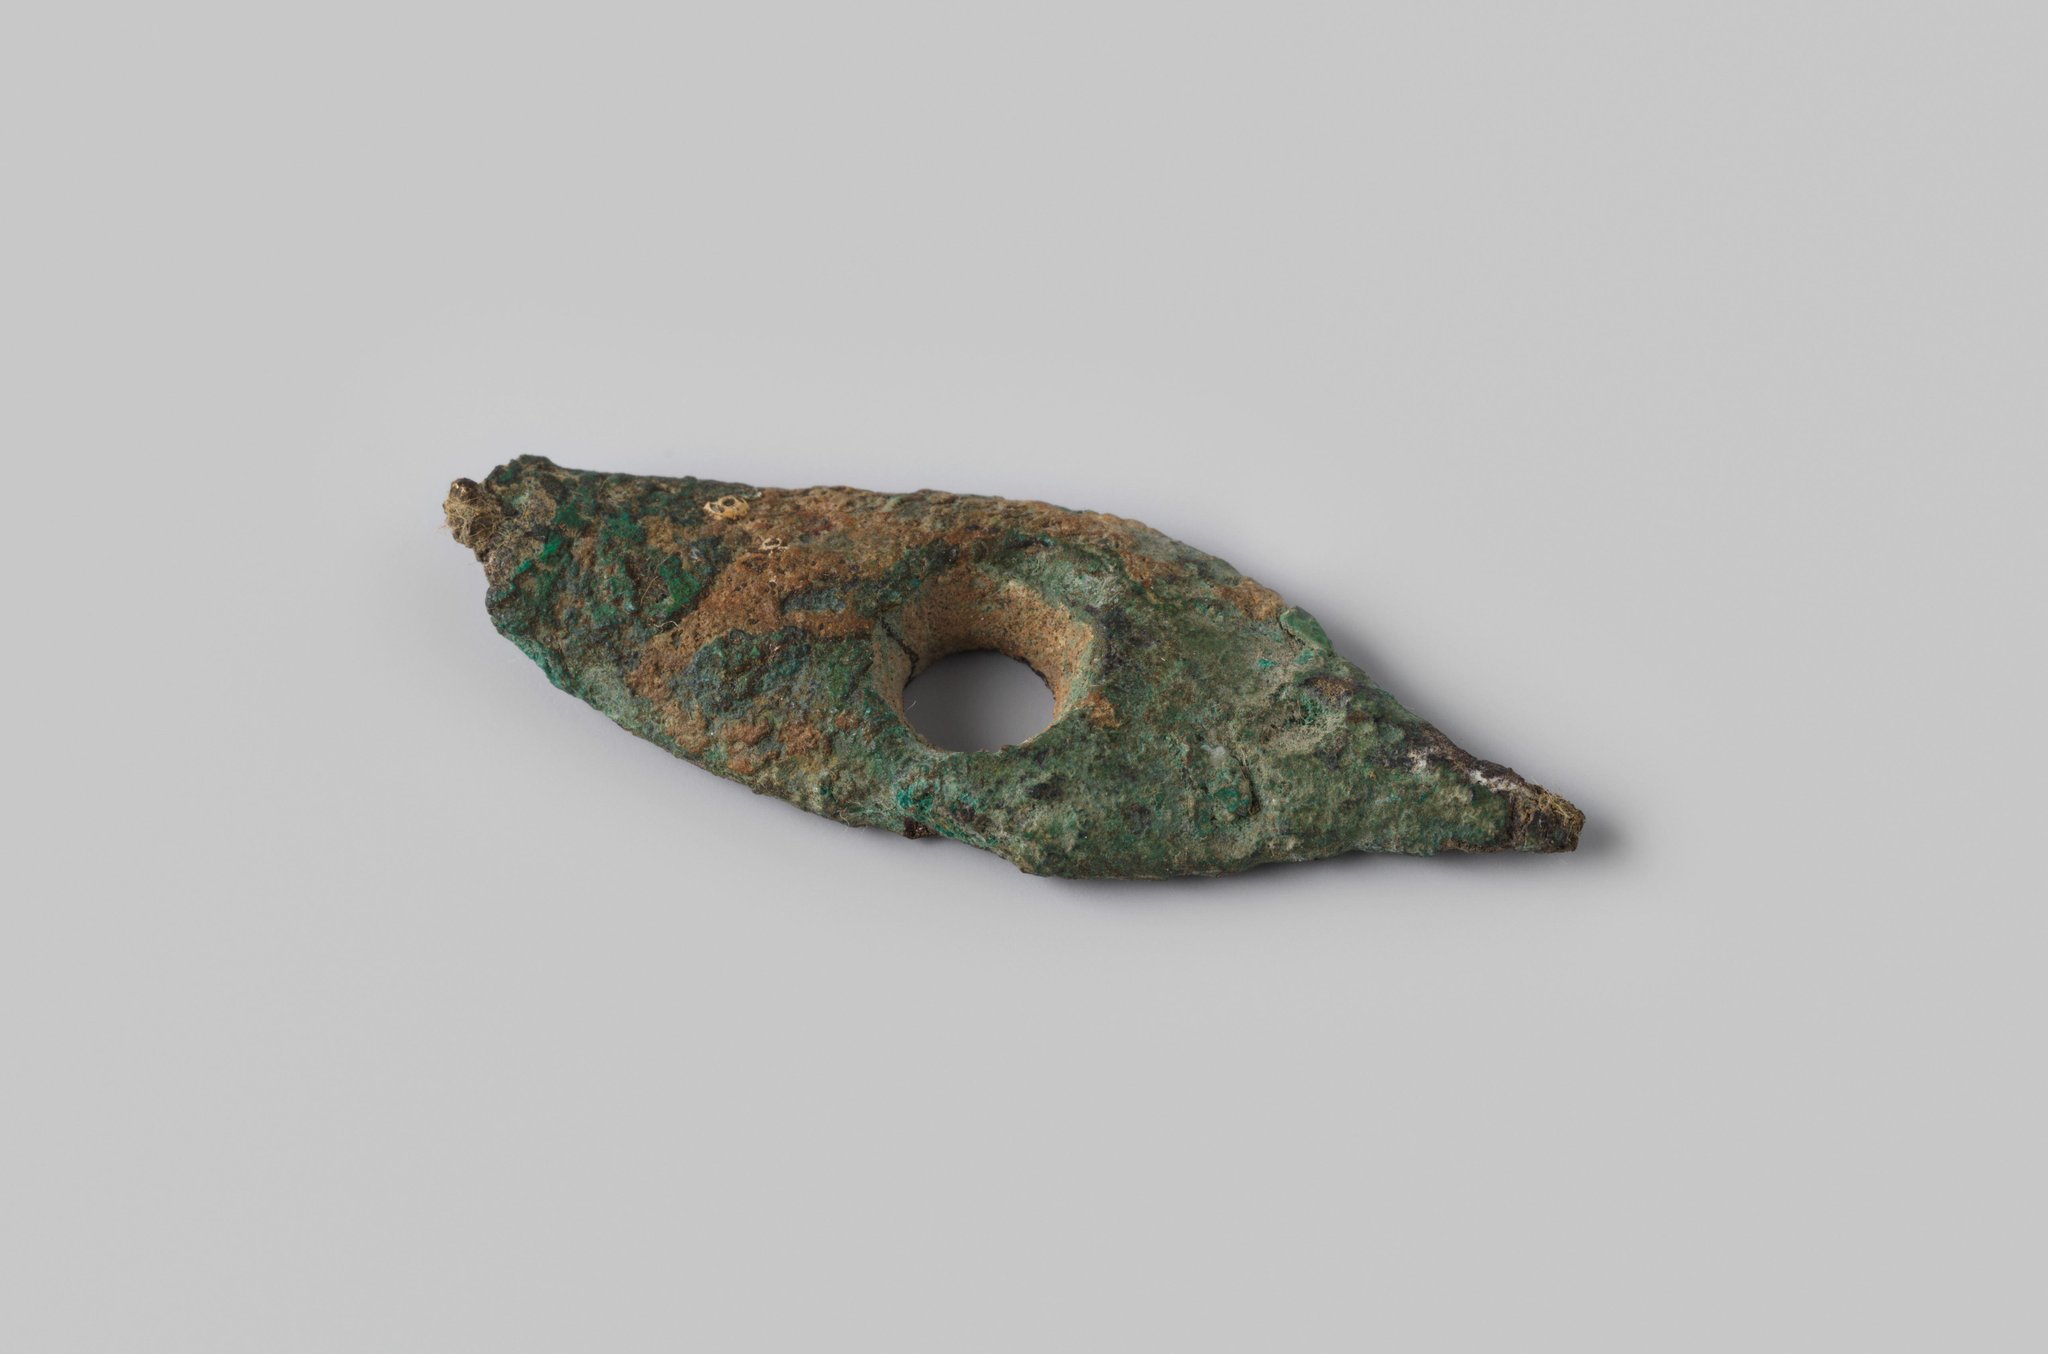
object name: fragment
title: Fragment van koper uit het wrak van de Oost-Indiëvaarder Hollandia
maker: Anonymous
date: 1700-1743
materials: copper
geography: netherlands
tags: verenigde oostindische compagnie, hollandia (schip), annet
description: Varied parts or fragments, strips and strip-shaped fragments; fragm.